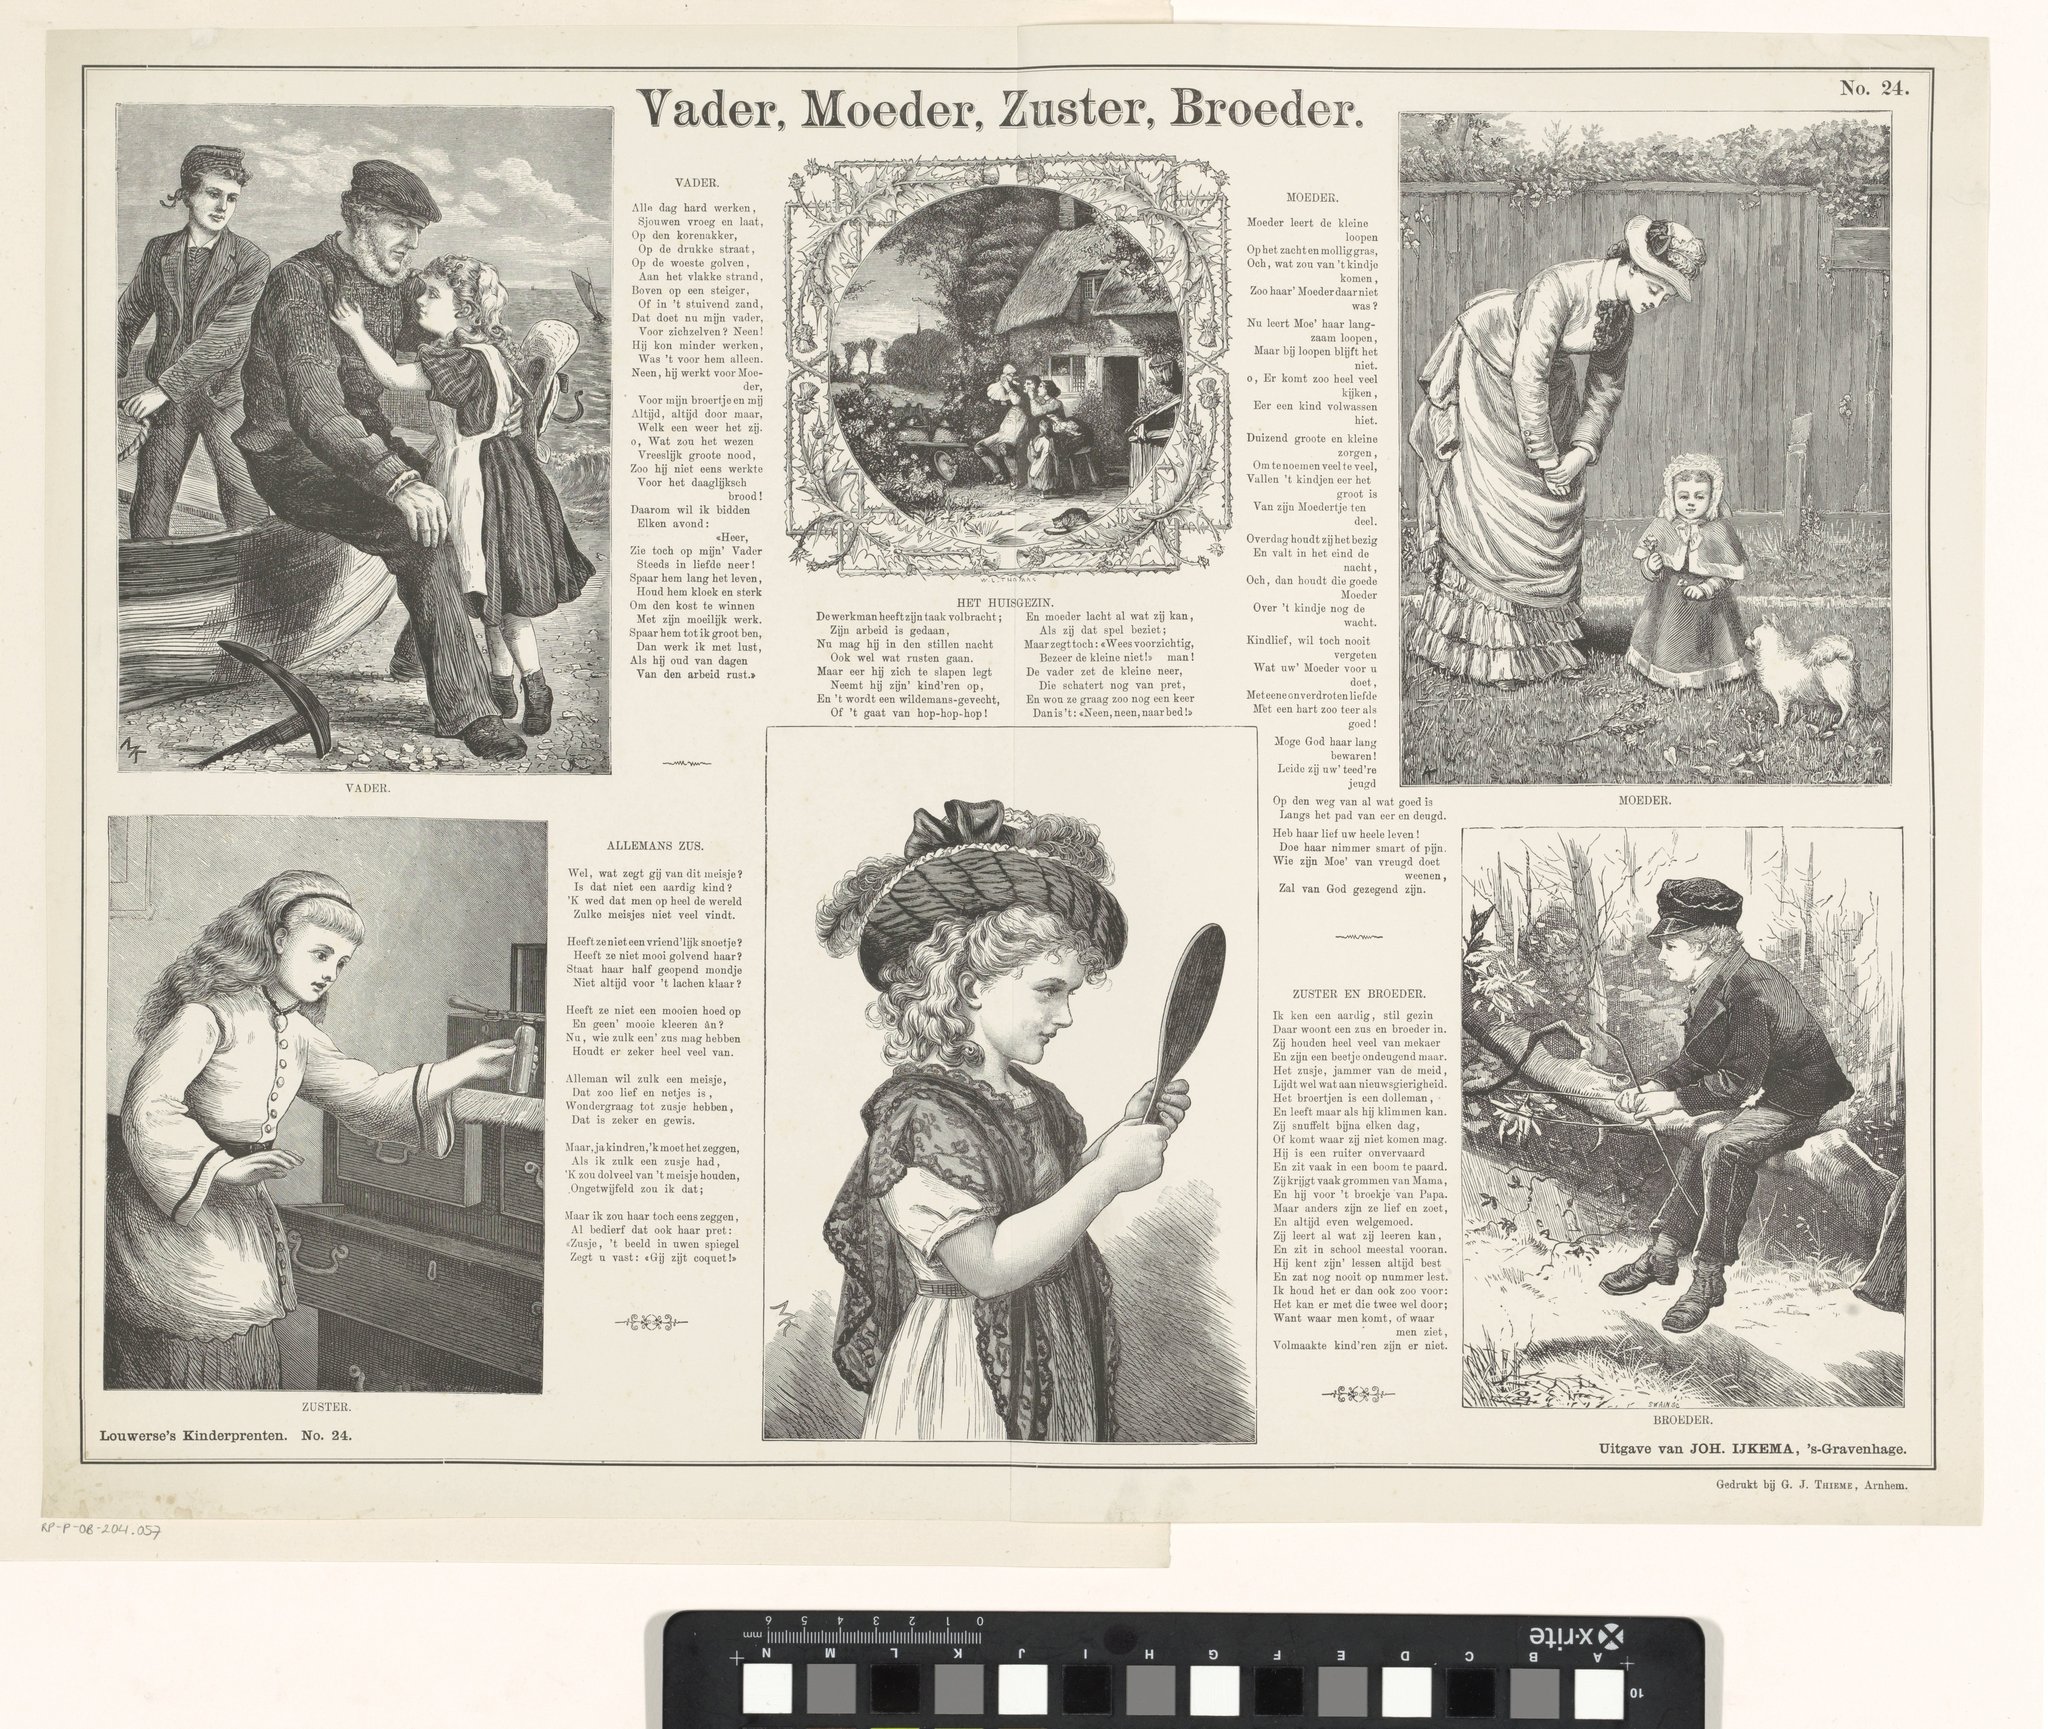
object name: popular print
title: Vader, moeder, zuster, broeder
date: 1882-1905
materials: paper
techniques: letterpress printing, printing block, engraving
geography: arnhem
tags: family, descendance, sisters (second degree family relationships), children (first degree family relationships), parents (first degree family relationships), brothers (second degree family relationships)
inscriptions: collector's mark: Lugt 2760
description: Blad met 6 voorstellingen van leden van het gezin: vader, moeder, broer en zus. Tussen de afbeeldingen versjes in boekdruk. Genummerd rechtsboven en linksonder: No. 24.